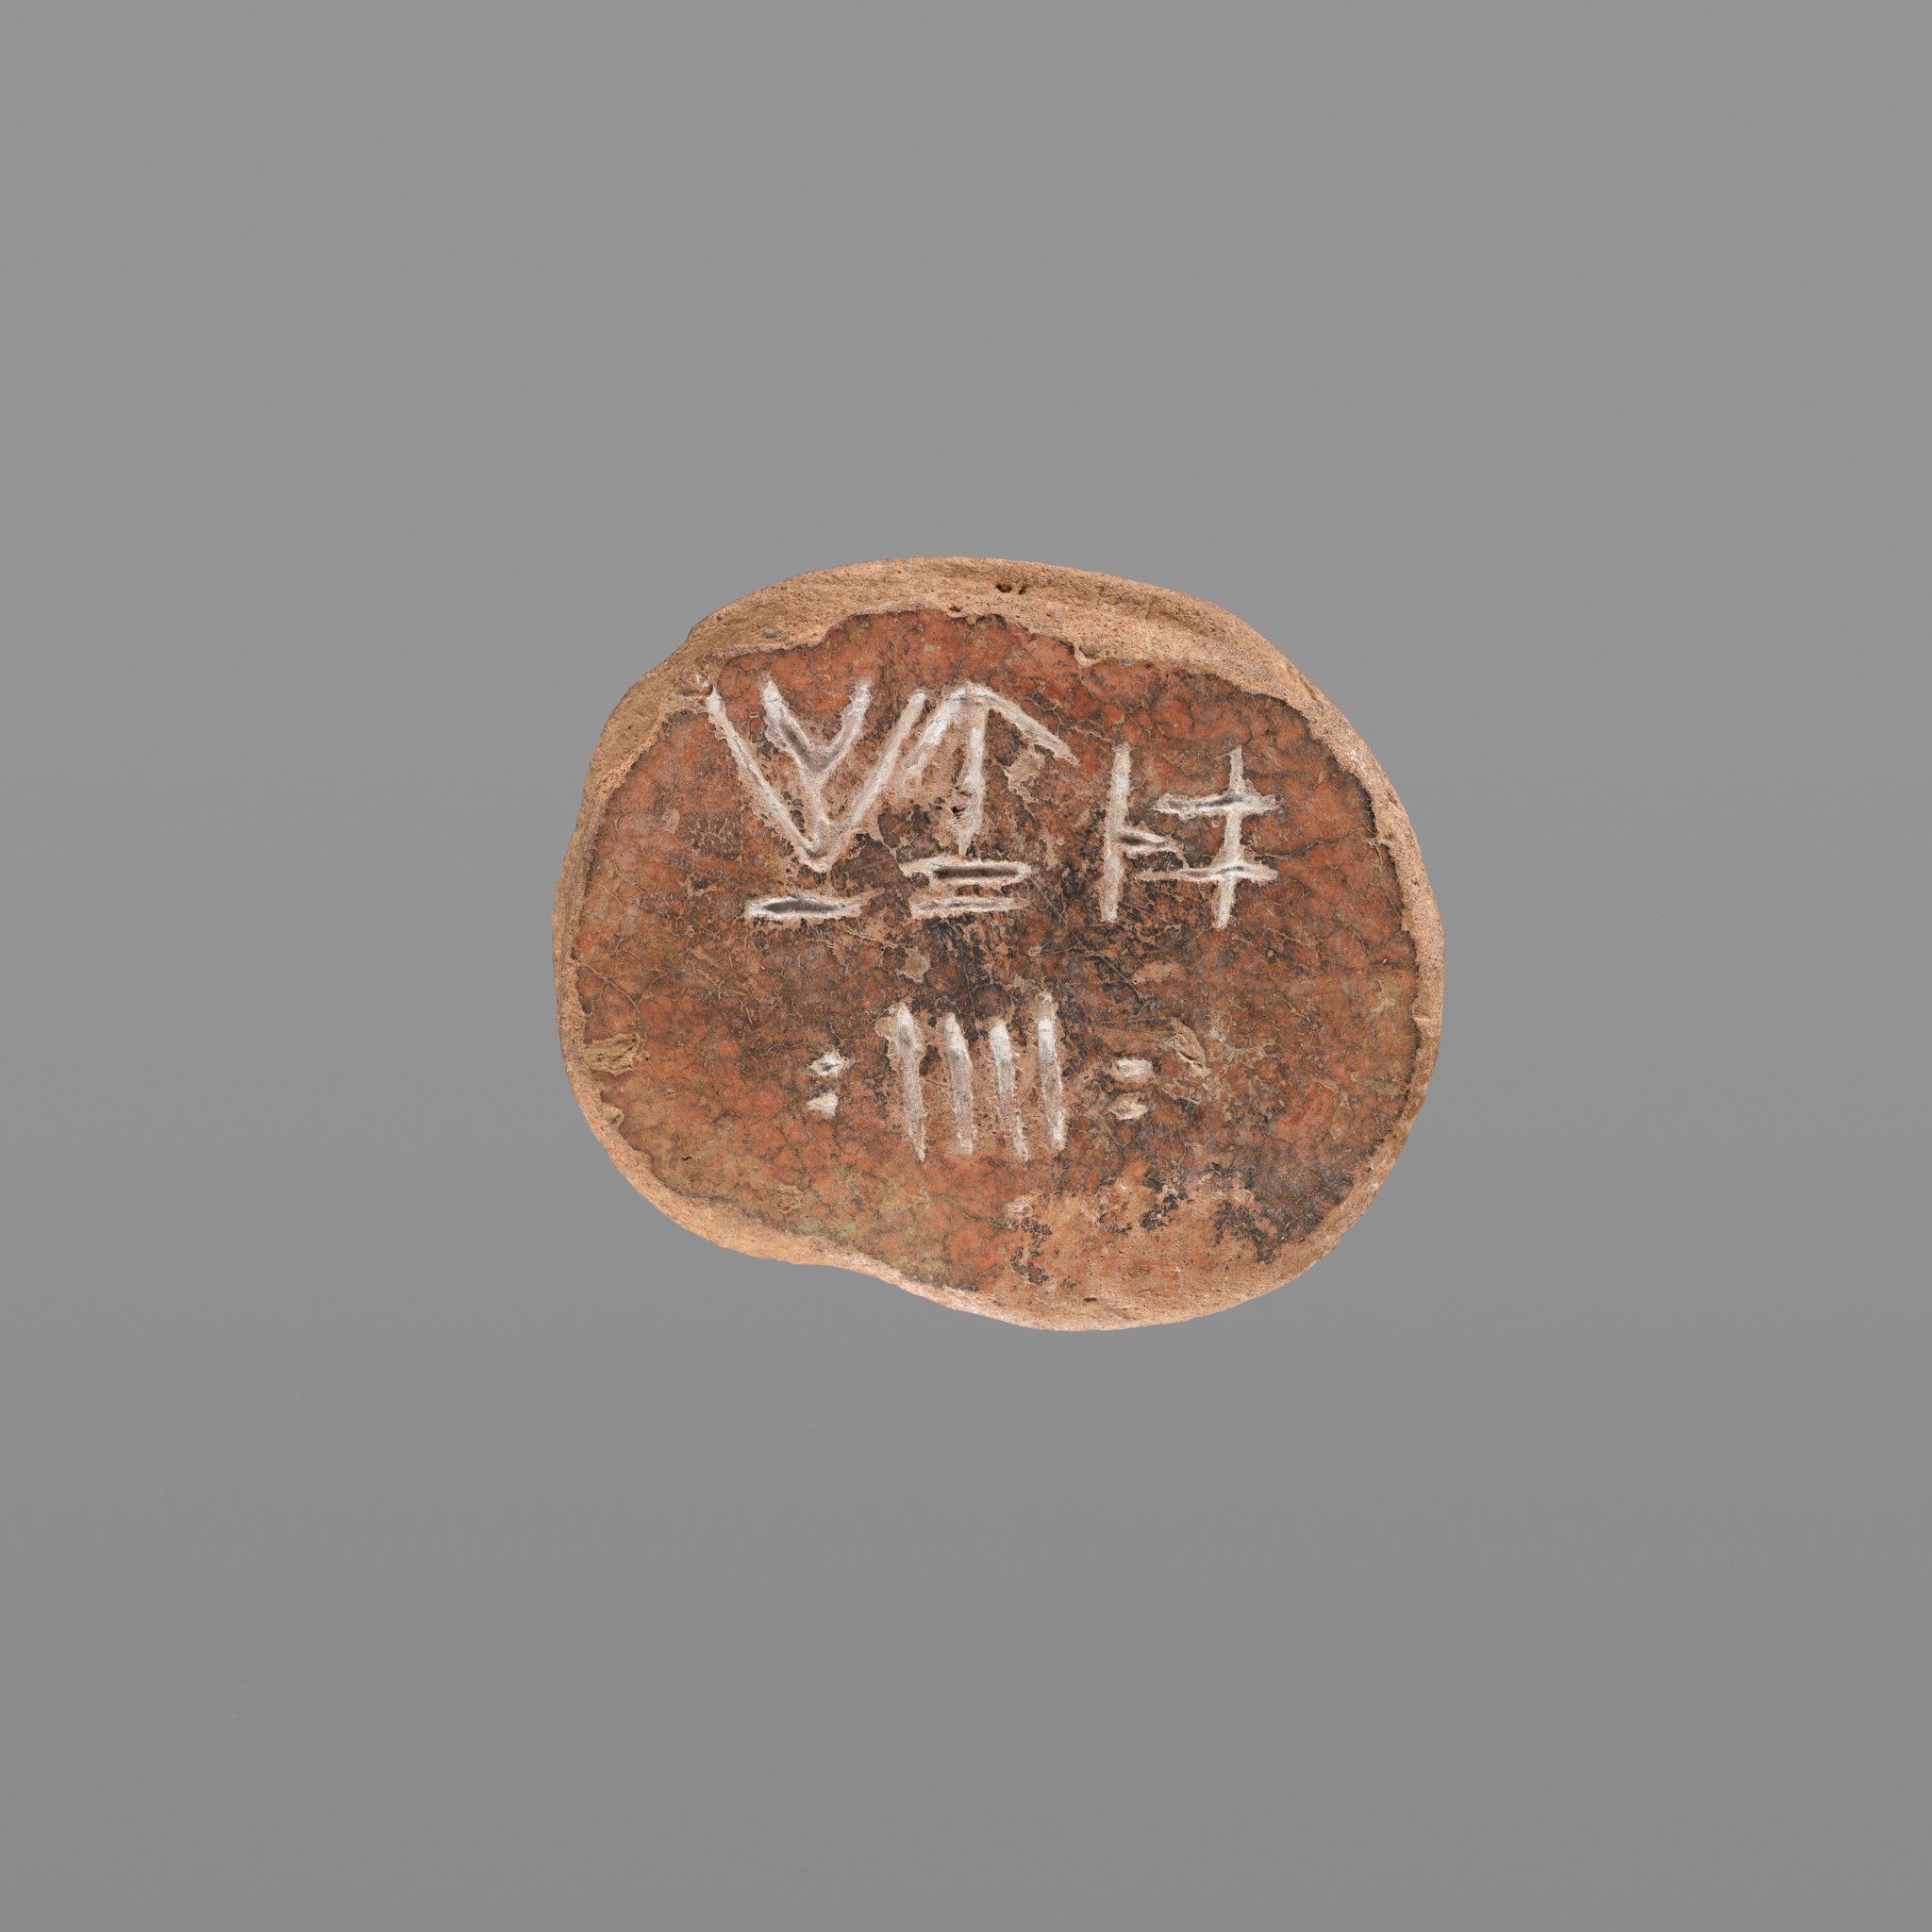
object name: disk, inscribed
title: Terracotta disk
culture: cypriot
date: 3900 BCE-100 CE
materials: terracotta